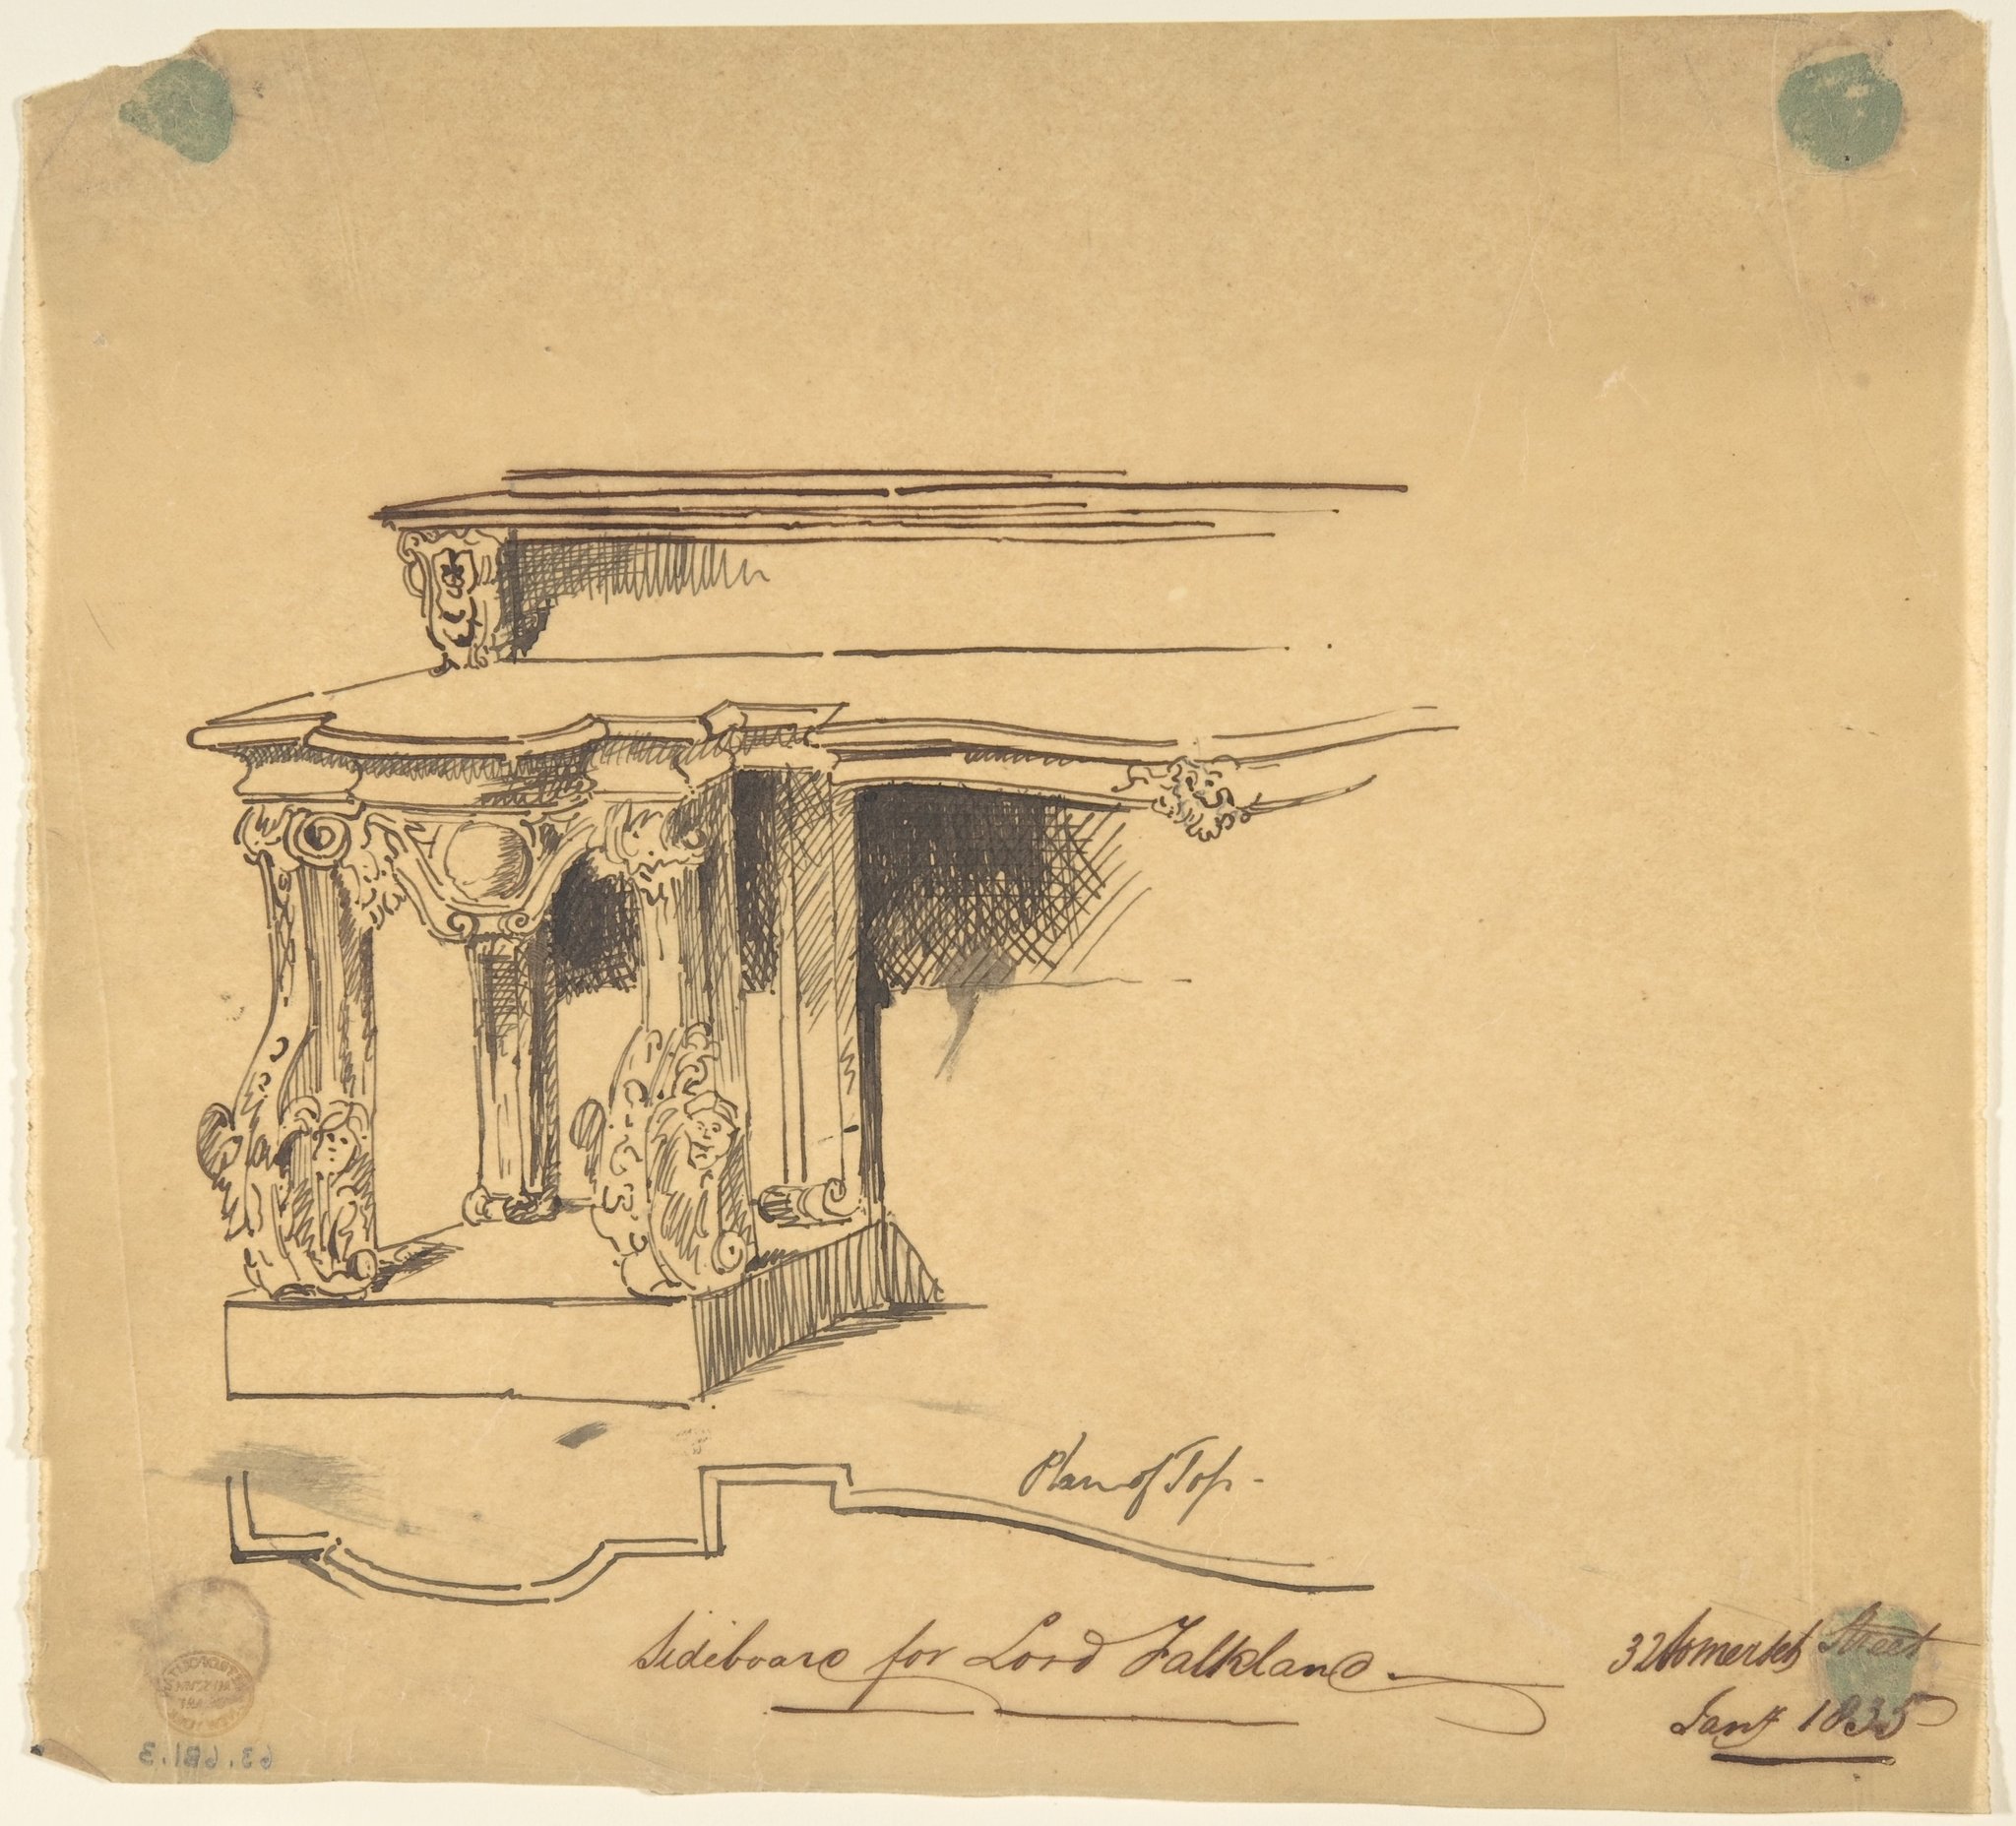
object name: drawing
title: Design for Sideboard for Lord Falklane at Skutterskelfe, Yorkshire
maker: anthony salvin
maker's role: artist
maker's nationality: british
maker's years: 1799-1881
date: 1835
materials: ink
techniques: pen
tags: furniture